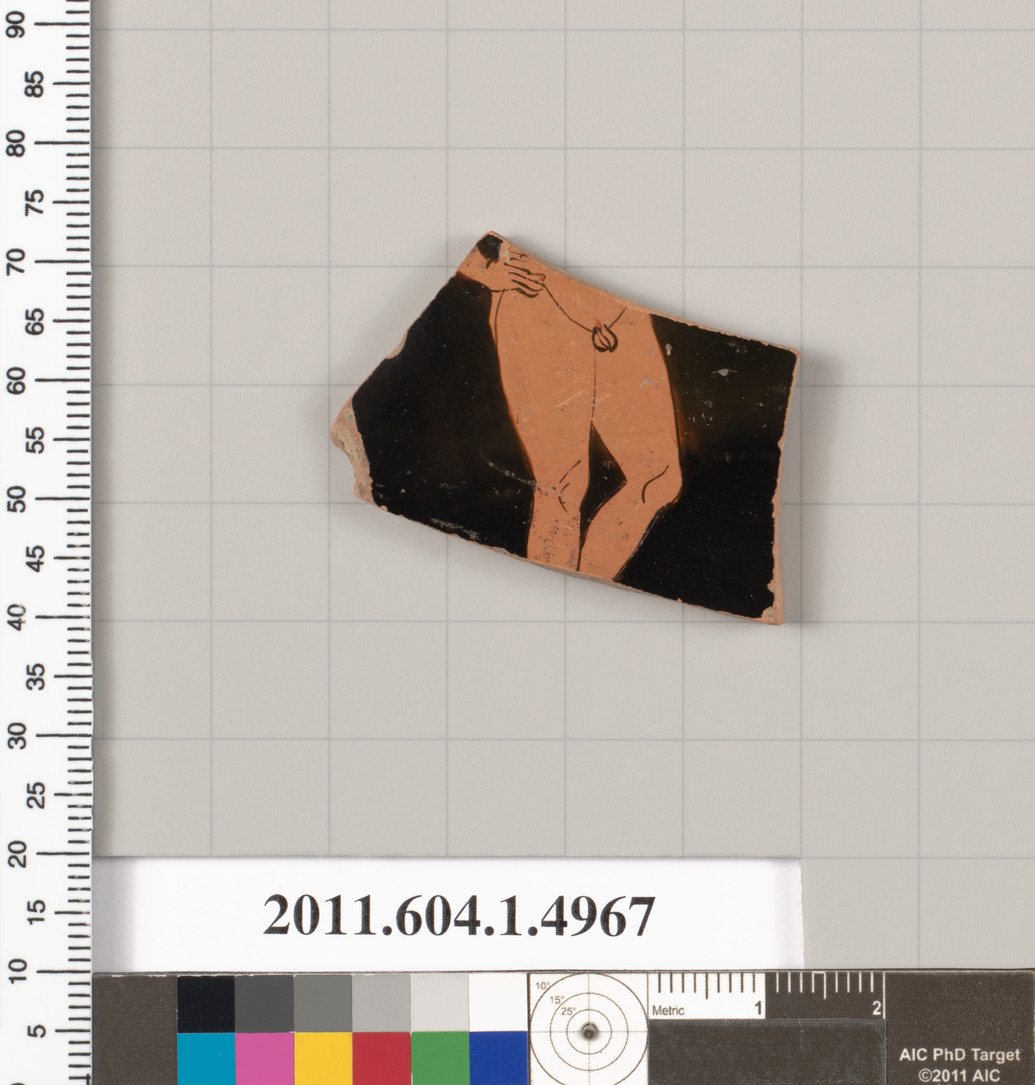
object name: kylix fragment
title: Terracotta fragment of a kylix (drinking cup)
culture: greek, attic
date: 467-435 BCE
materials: terracotta